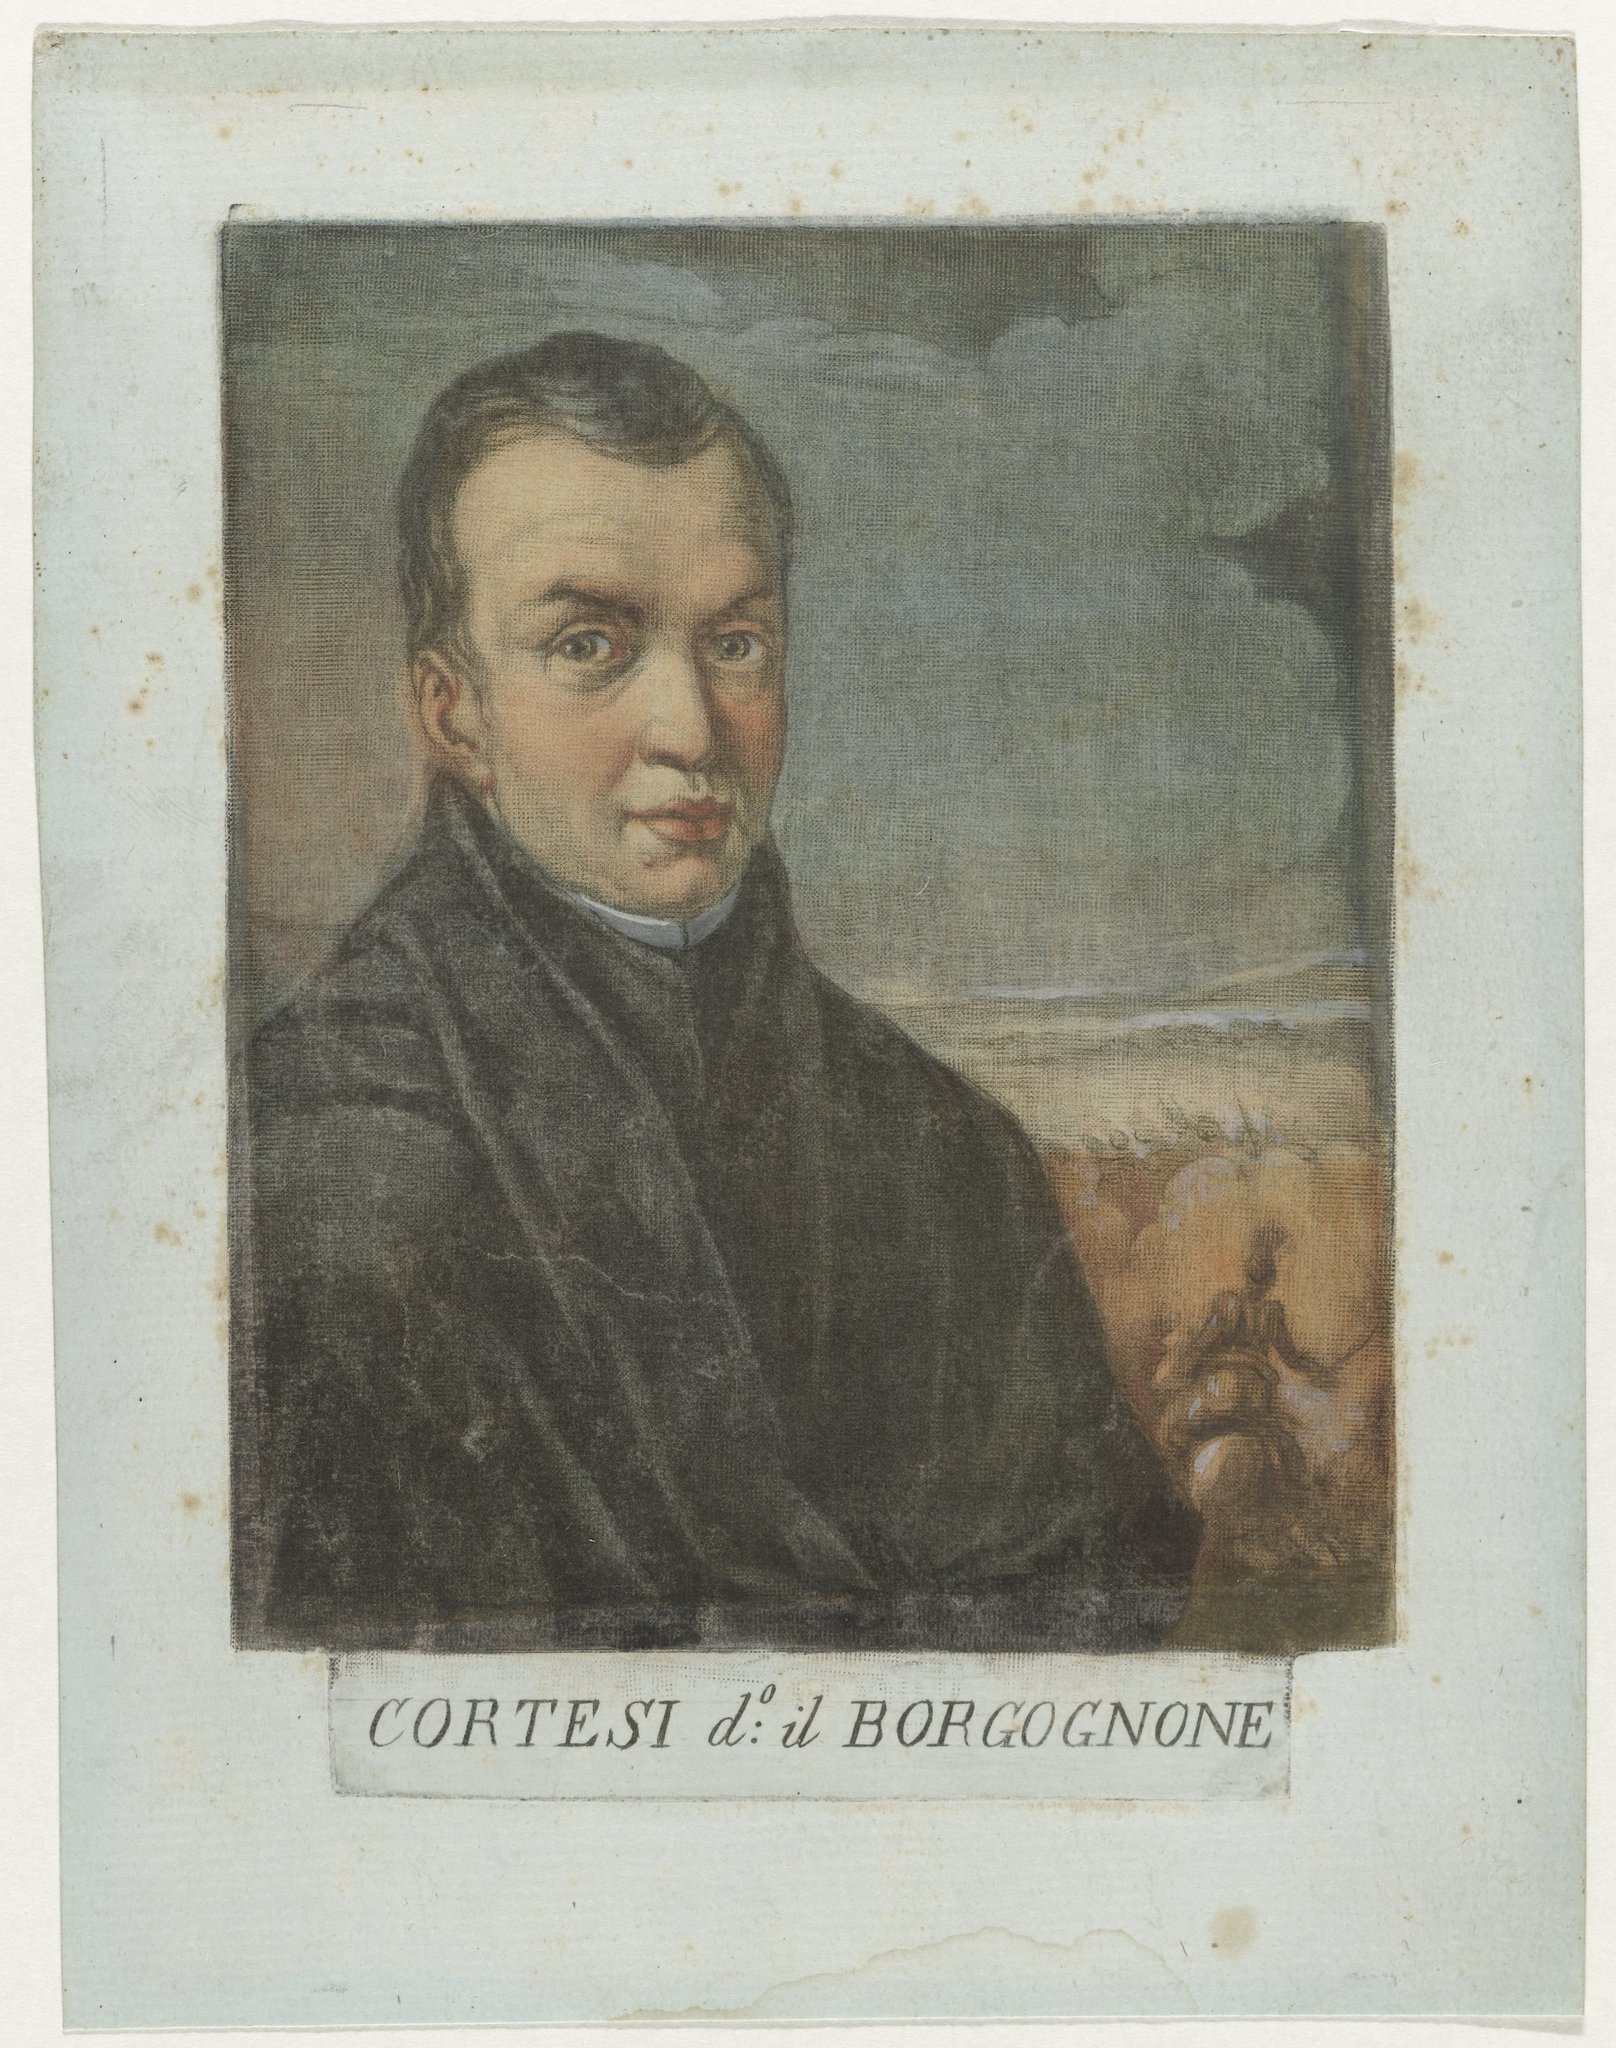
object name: print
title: Kunstenaarszelfportretten in de Galleria degli Uffizi te Florence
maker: carlo lasinio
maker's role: painter, print maker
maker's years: 1759-1838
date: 1789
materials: paper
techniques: brush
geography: italy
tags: rome, jacques courtois, historical persons, portrait, self-portrait of artist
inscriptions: collector's mark: Lugt 2228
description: Naar een geschilderd zelfportret door Courtois in de Galleria degli Uffizi te Florence. Prent uit: Carlo Lasiano, Gli Autoritratti della Real Galleria di Firenze, 1789.